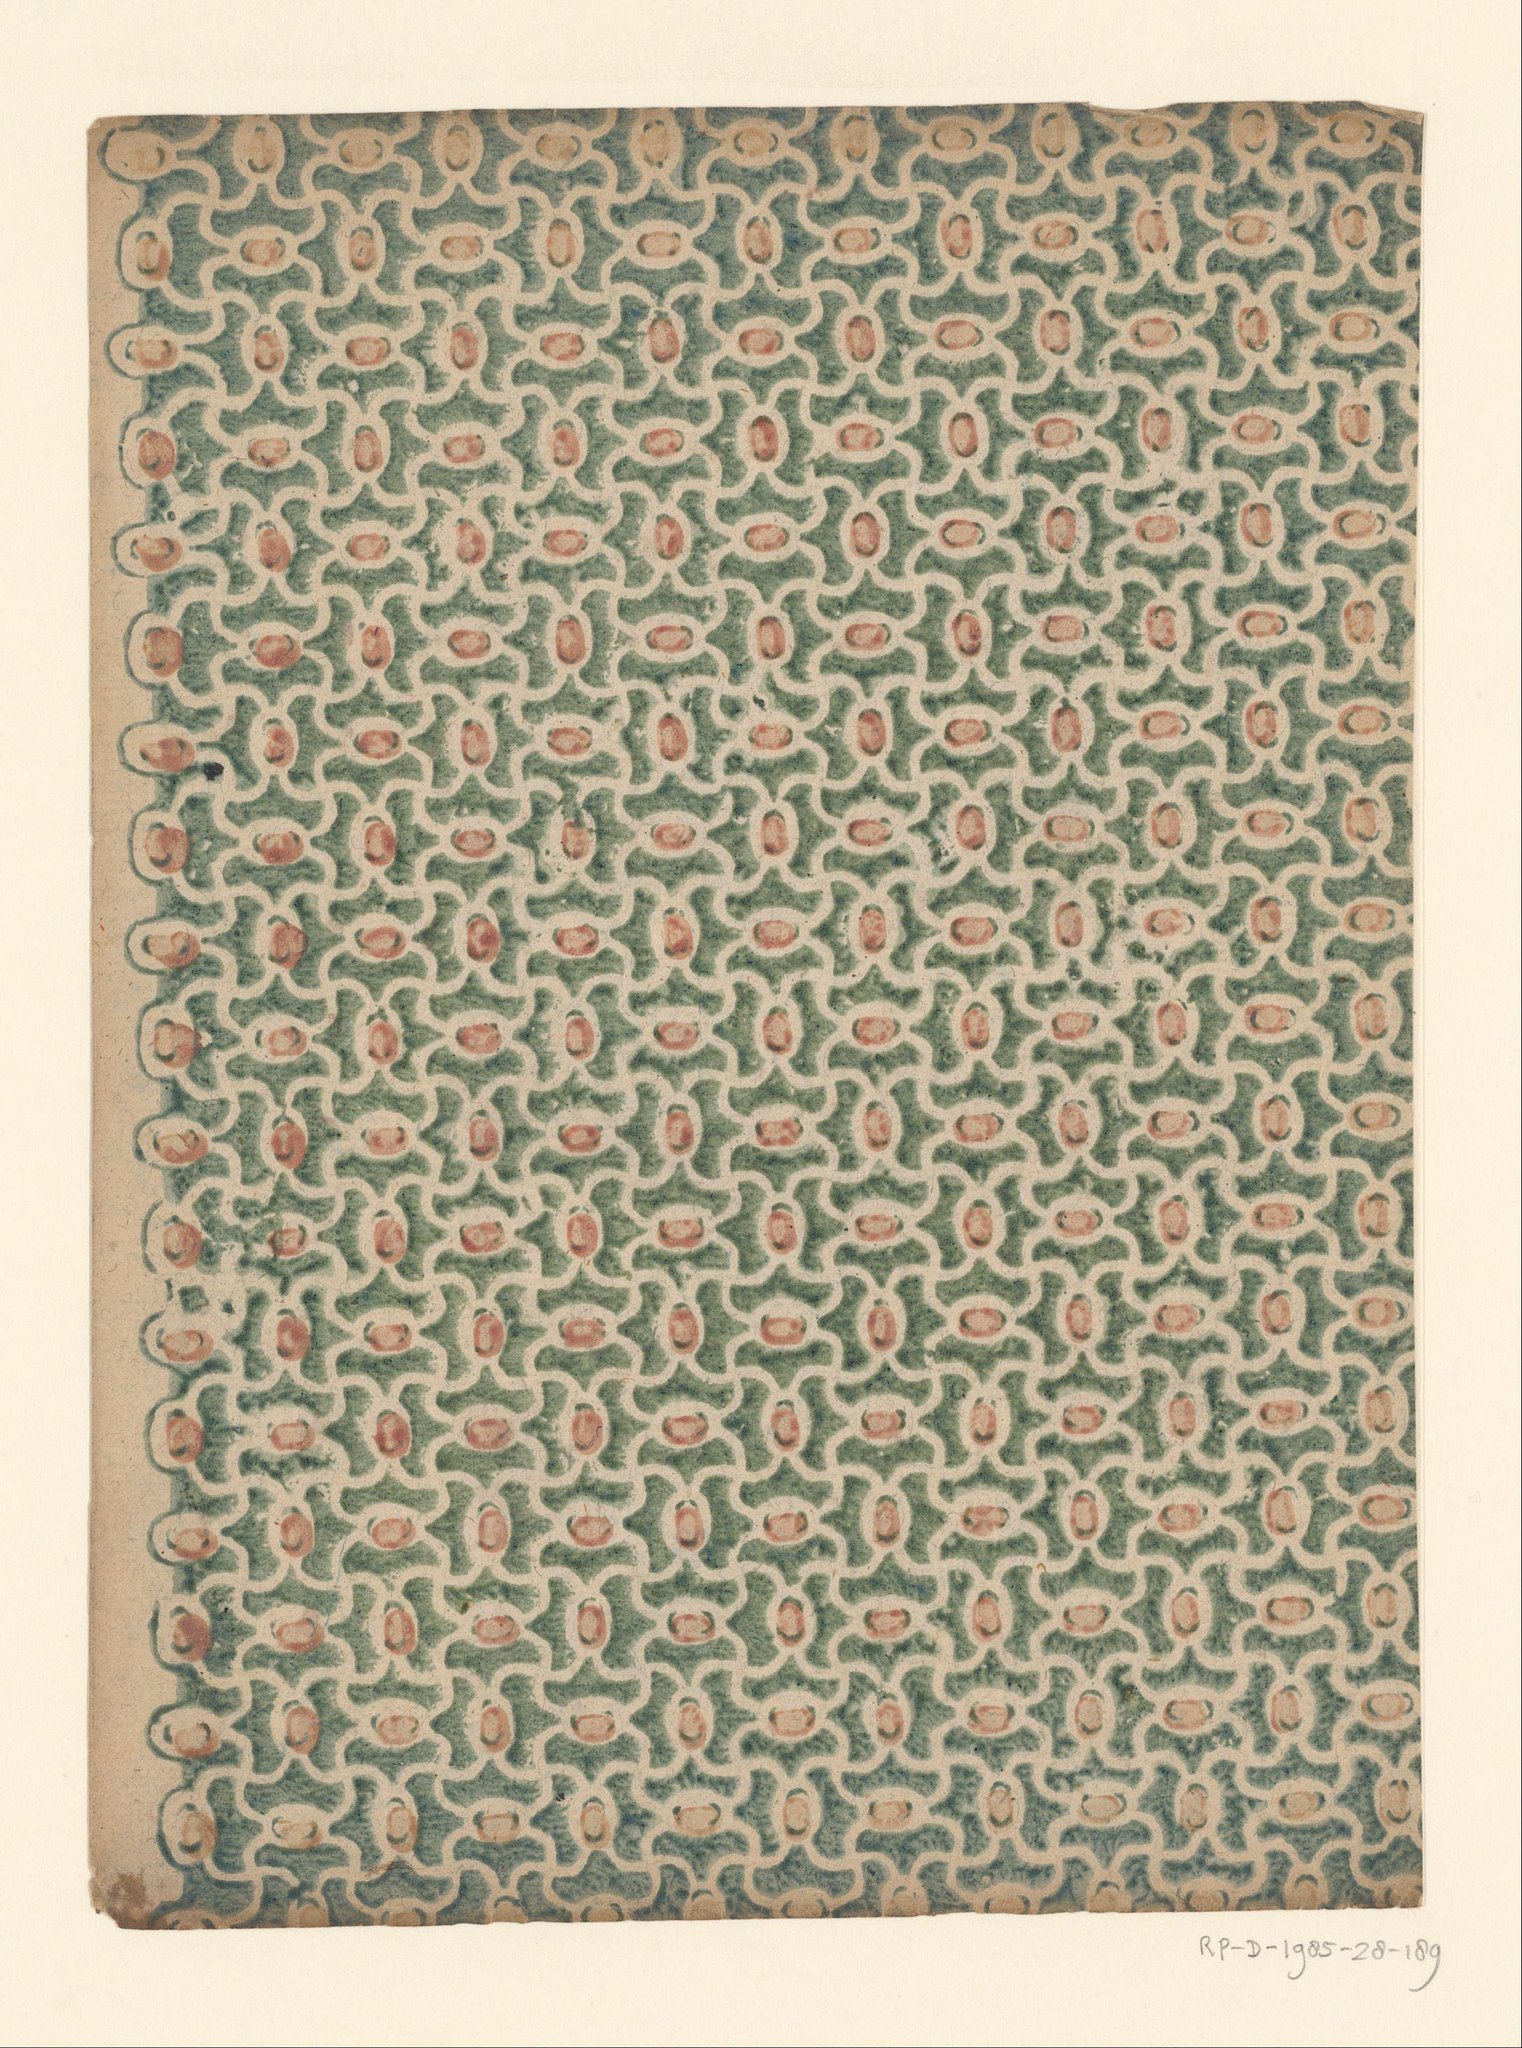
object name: printed paper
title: Blad met patroon van uitgespaarde kronkelende lijnen met ovaal motief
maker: Anonymous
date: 1750-1900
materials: paper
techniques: printing block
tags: fantasy ornament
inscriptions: collector's mark: Lugt 2228, collector's mark: Lugt 2760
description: Blad met patroon van uitgespaarde kronkelende lijnen met ovaal motief. Helft van een omslag.